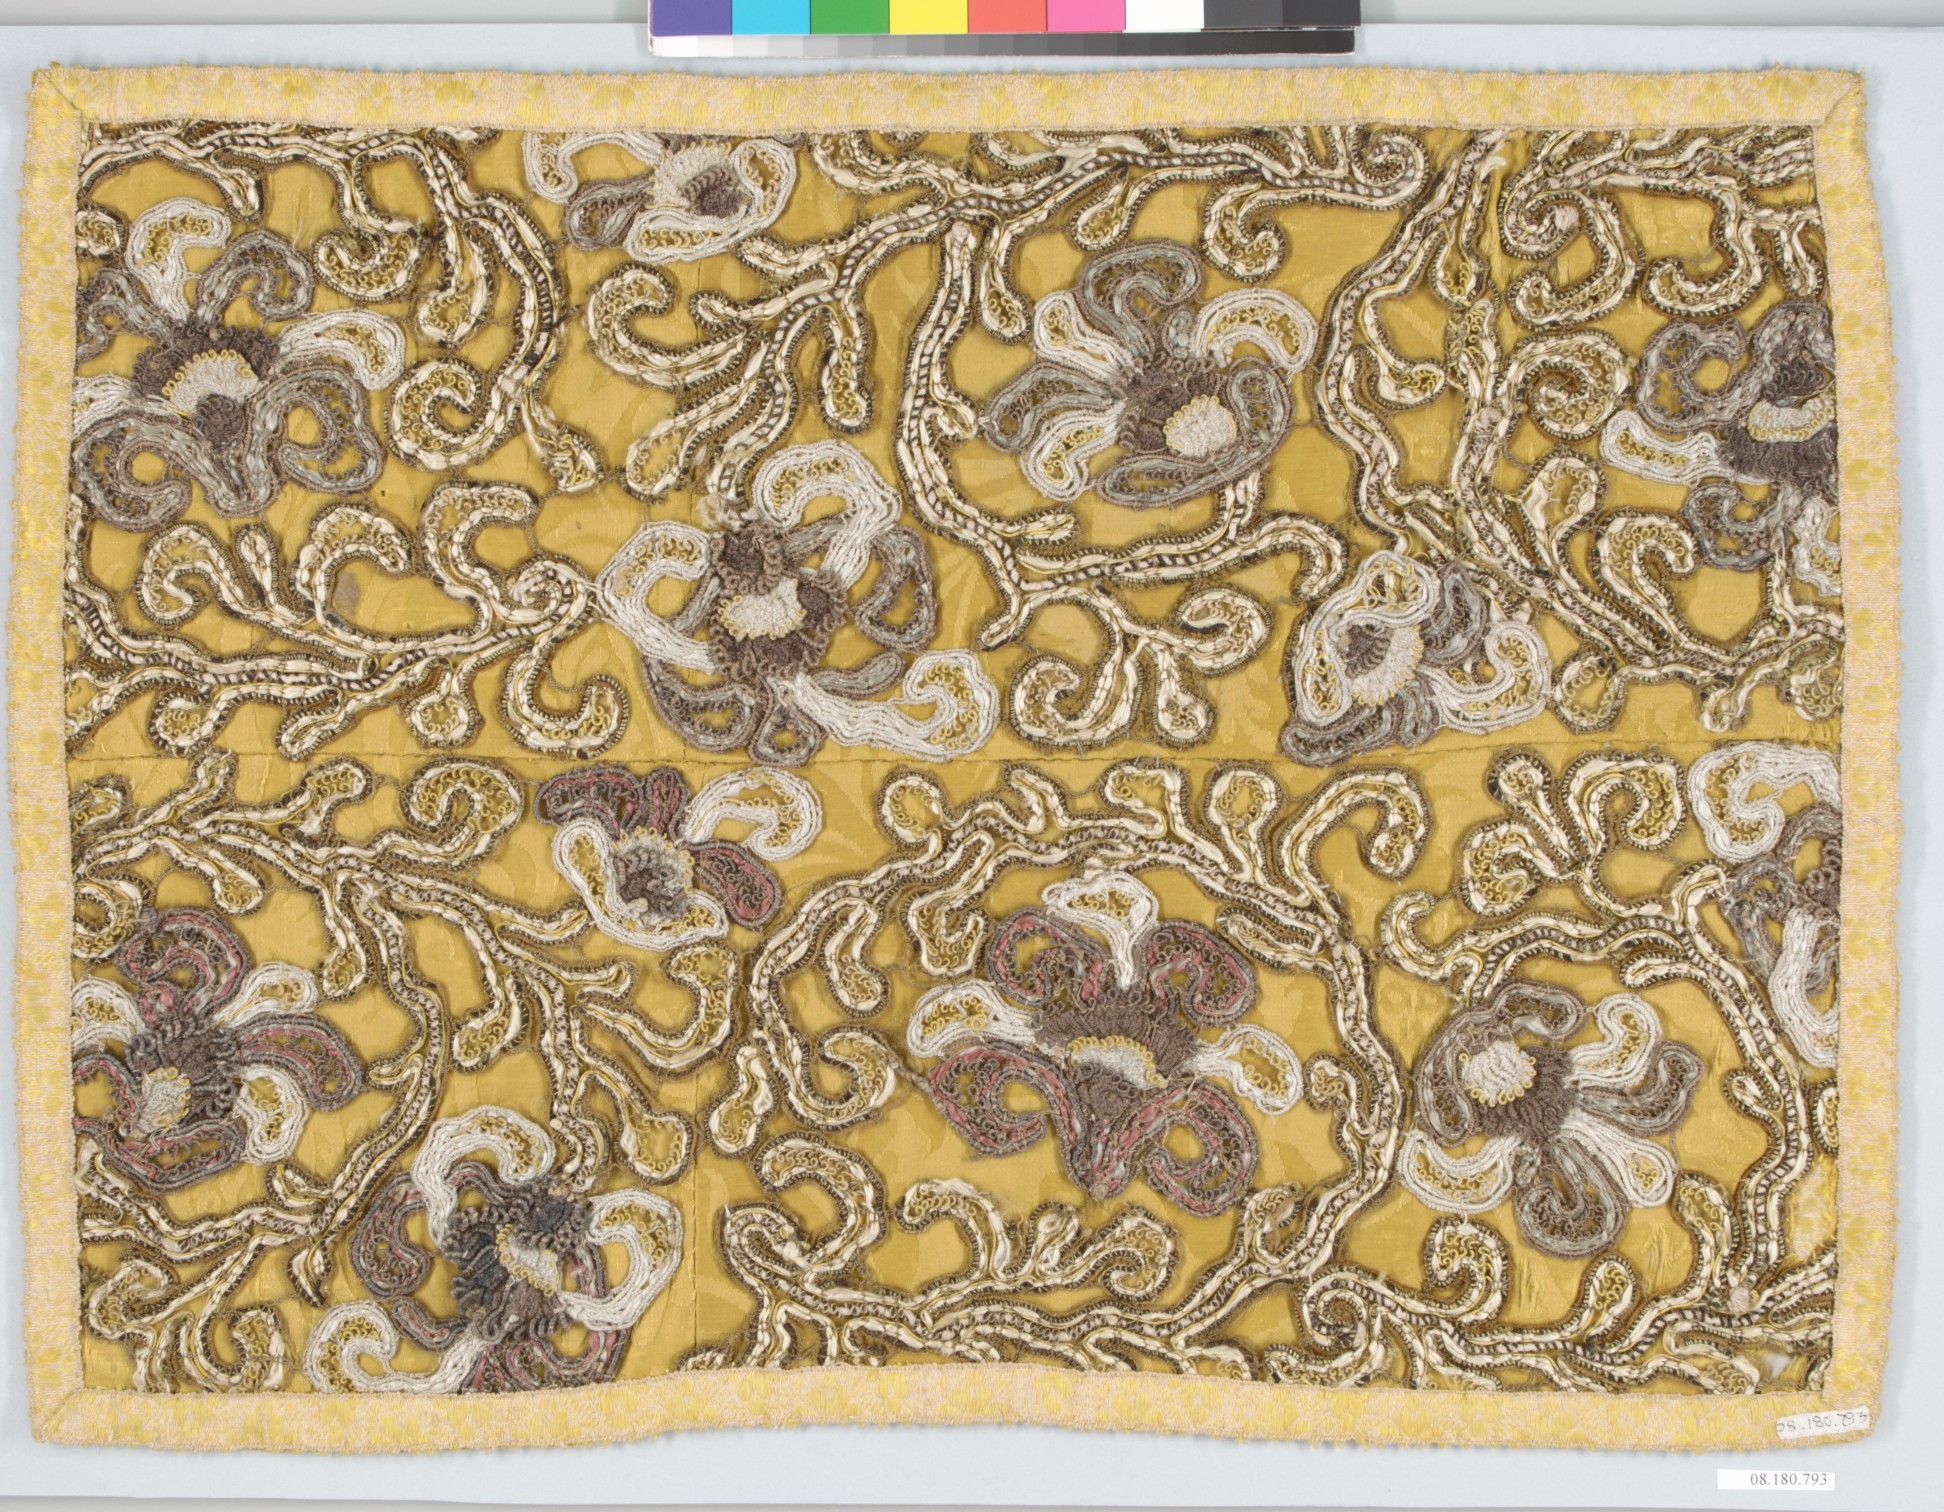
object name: passementerie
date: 1601-1700